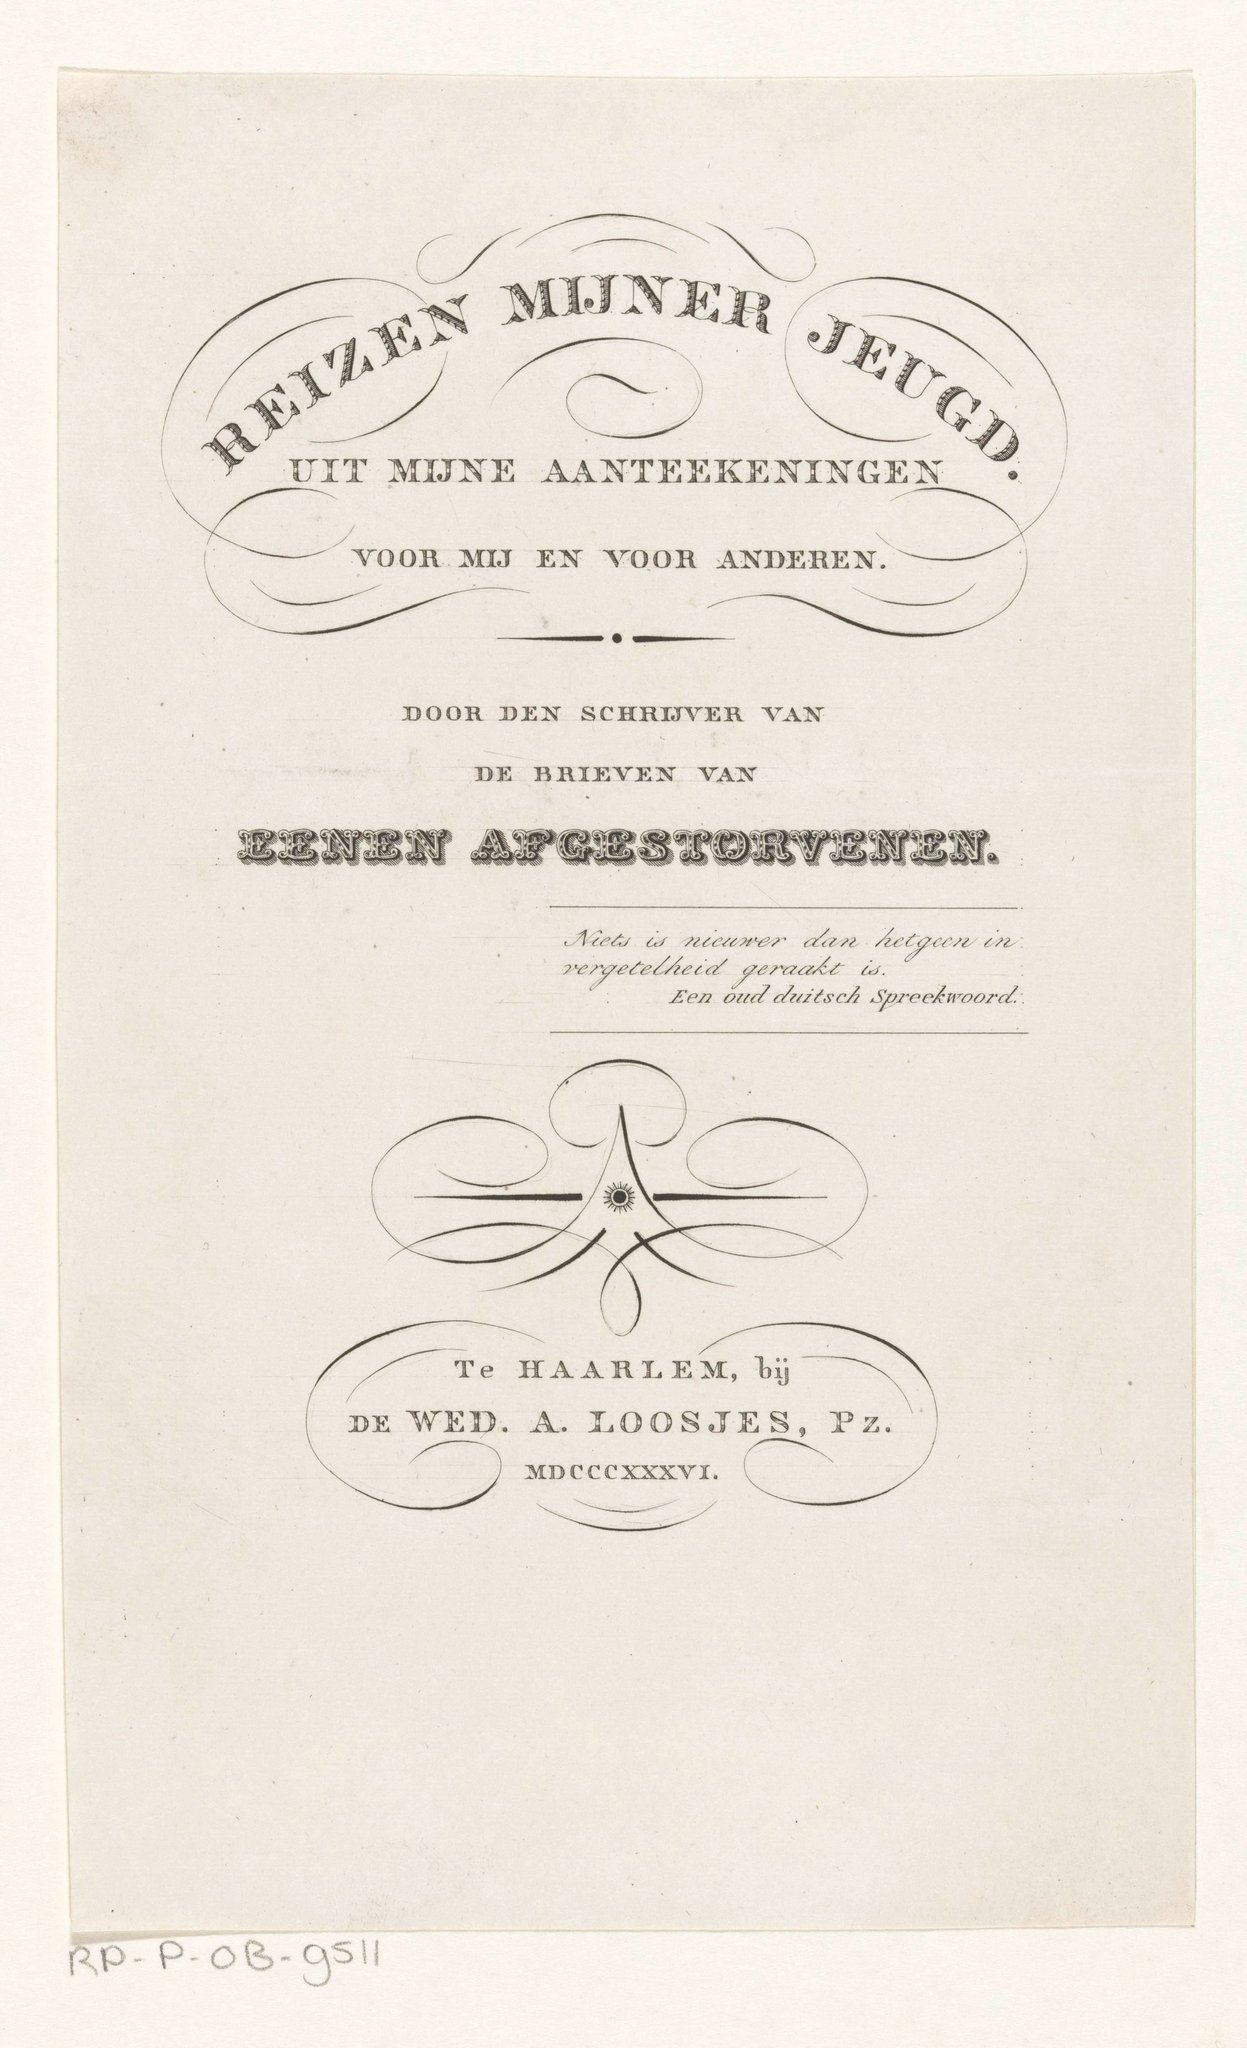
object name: titelblad, titelpagina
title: Titelpagina voor: H.L.H. von Pückler-Muskau, Reizen mijner jeugd. Uit mijner aanteekeningen voor mij en voor anderen, 1836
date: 1836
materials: paper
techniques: engraving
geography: haarlem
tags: title-page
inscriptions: collector's mark: Lugt 2228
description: Titelpagina voor: Pückler-Muskau, H.L.H. von. Reizen mijner jeugd. Uit mijner aanteekeningen voor mij en voor anderen. Haarlem: Loosjes Pz., weduwe Adriaan, 1836.